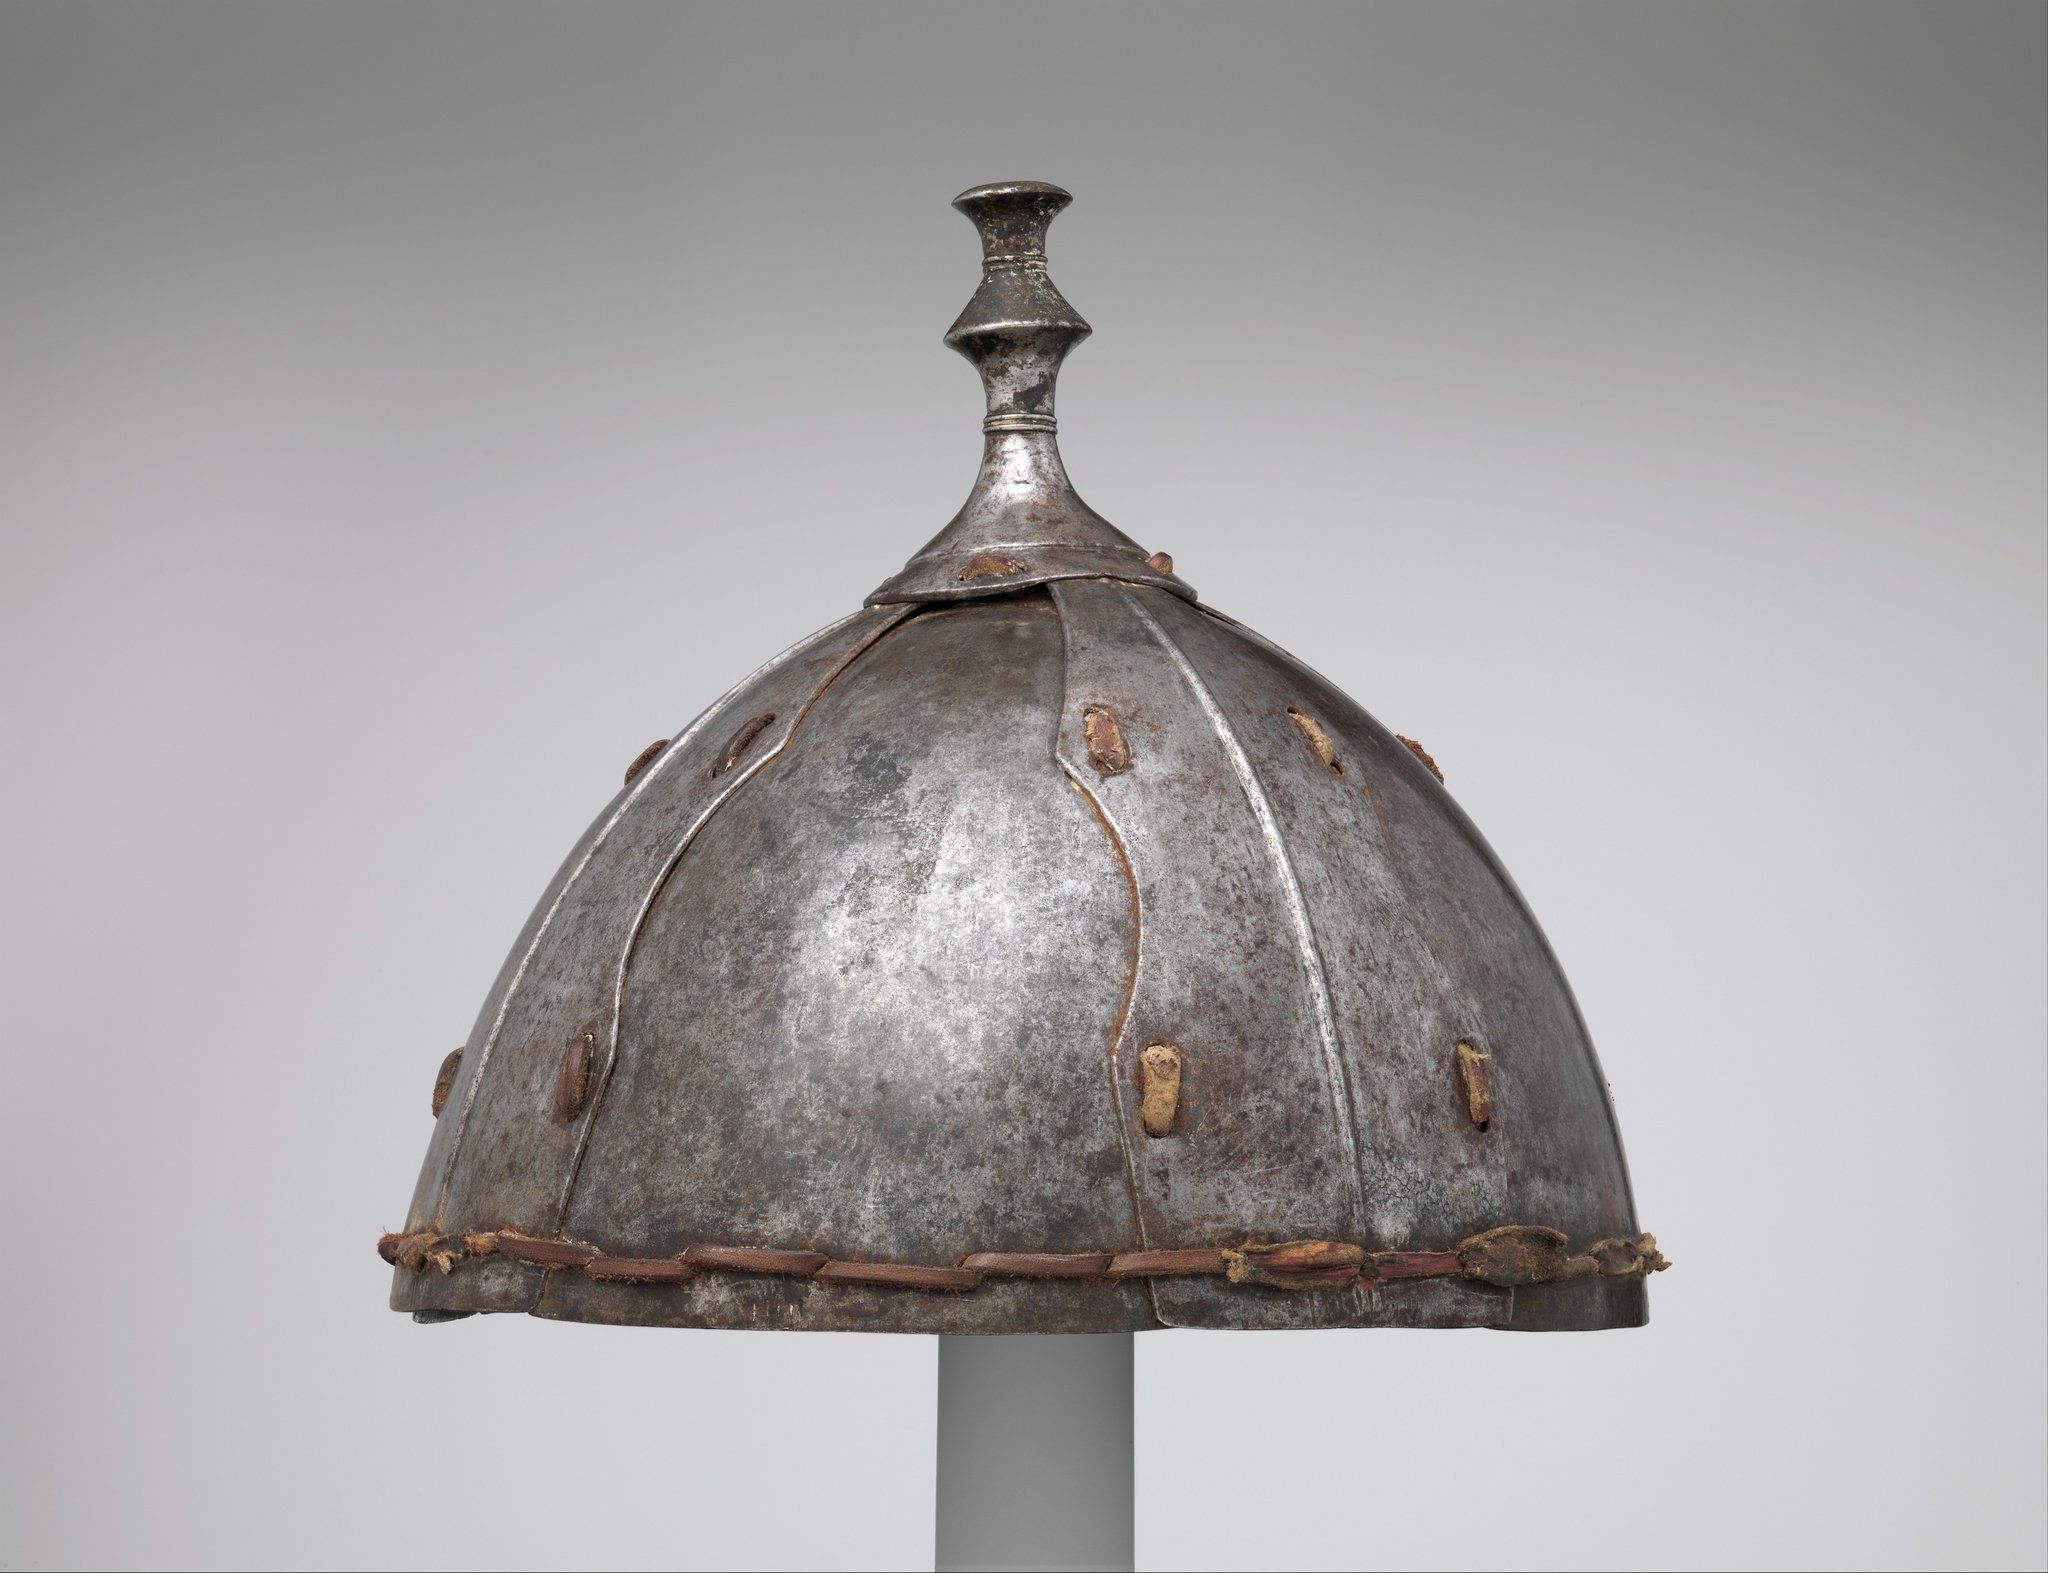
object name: helmet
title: Eight-Plate Helmet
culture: tibetan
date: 1501-1700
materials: iron, leather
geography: tibet